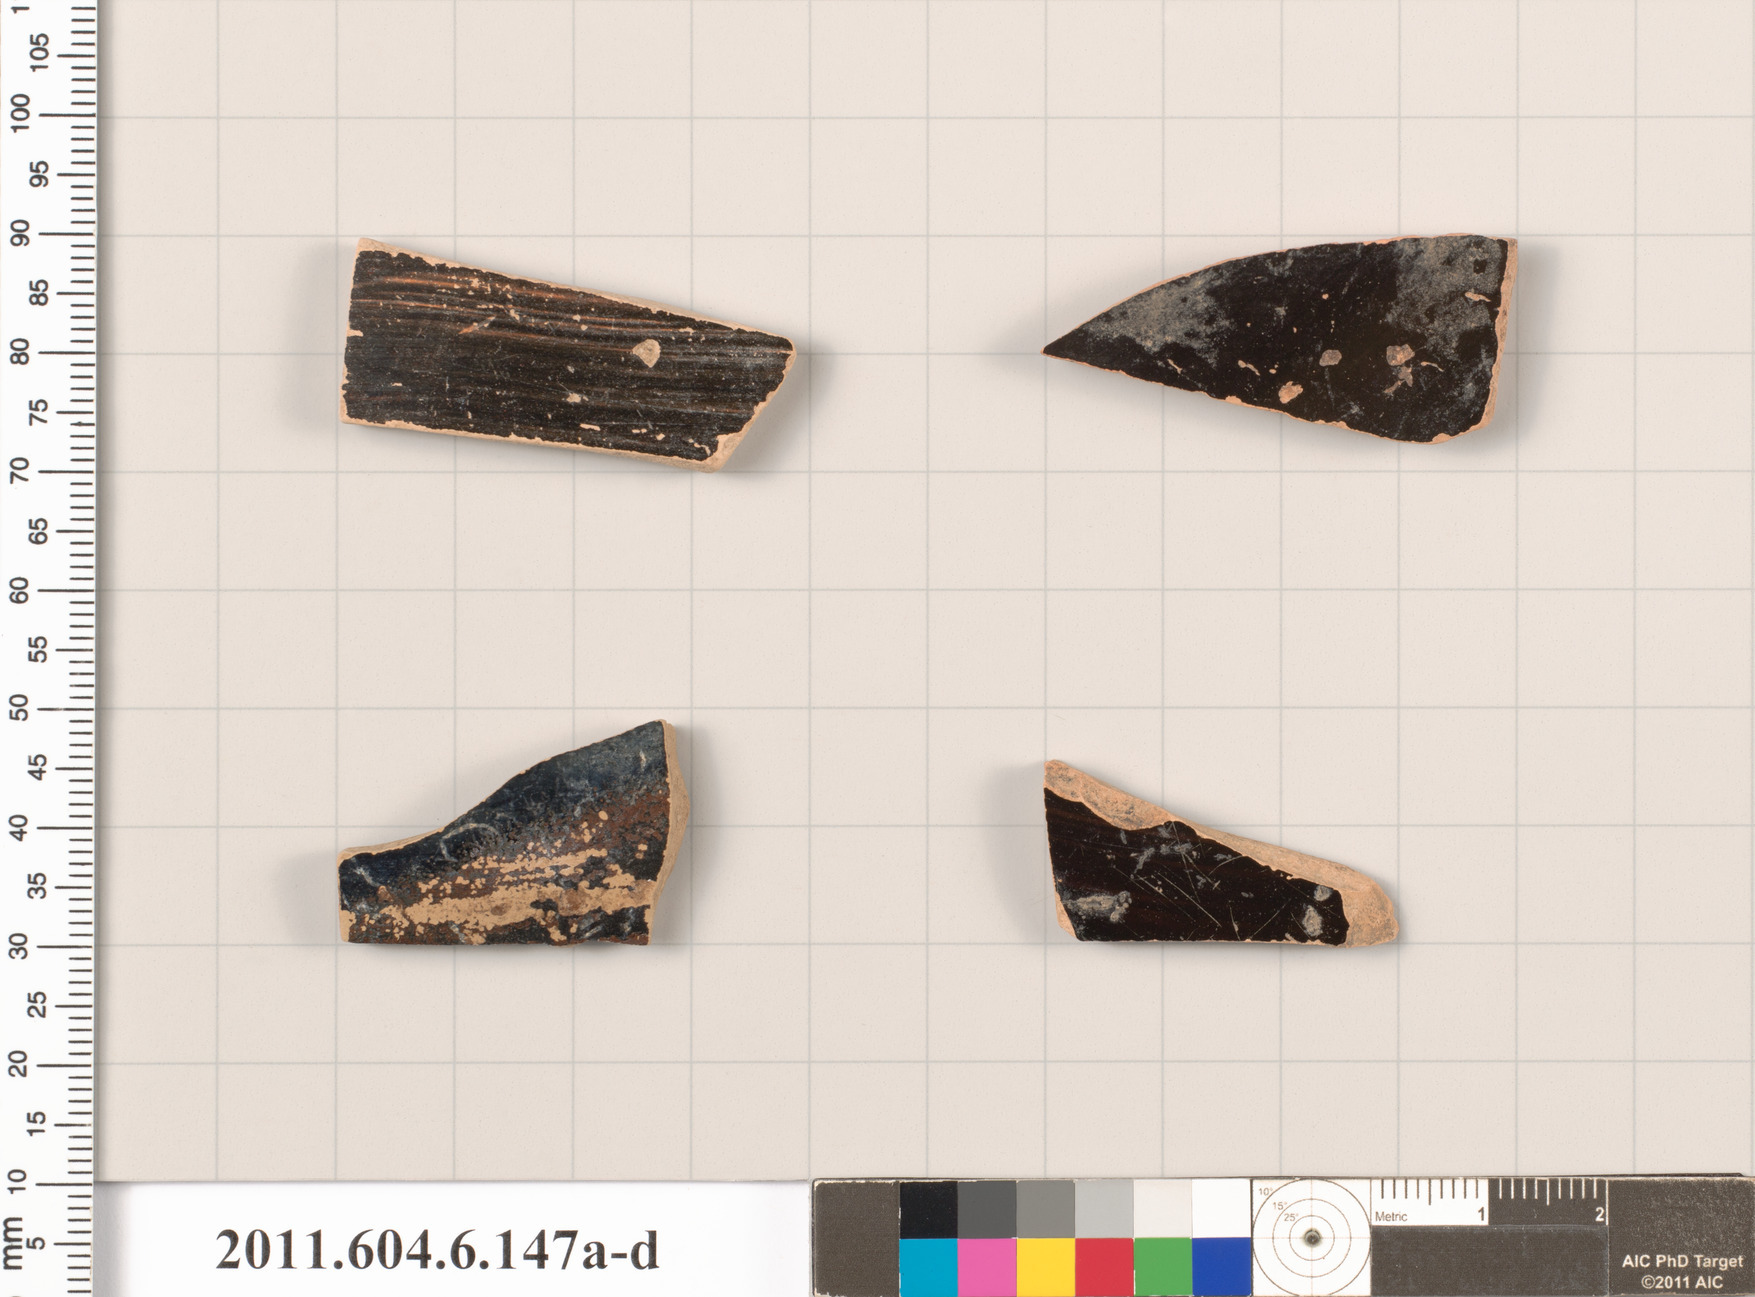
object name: undetermined open shape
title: Terracotta fragments of open shapes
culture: greek, attic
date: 600-401 BCE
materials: terracotta